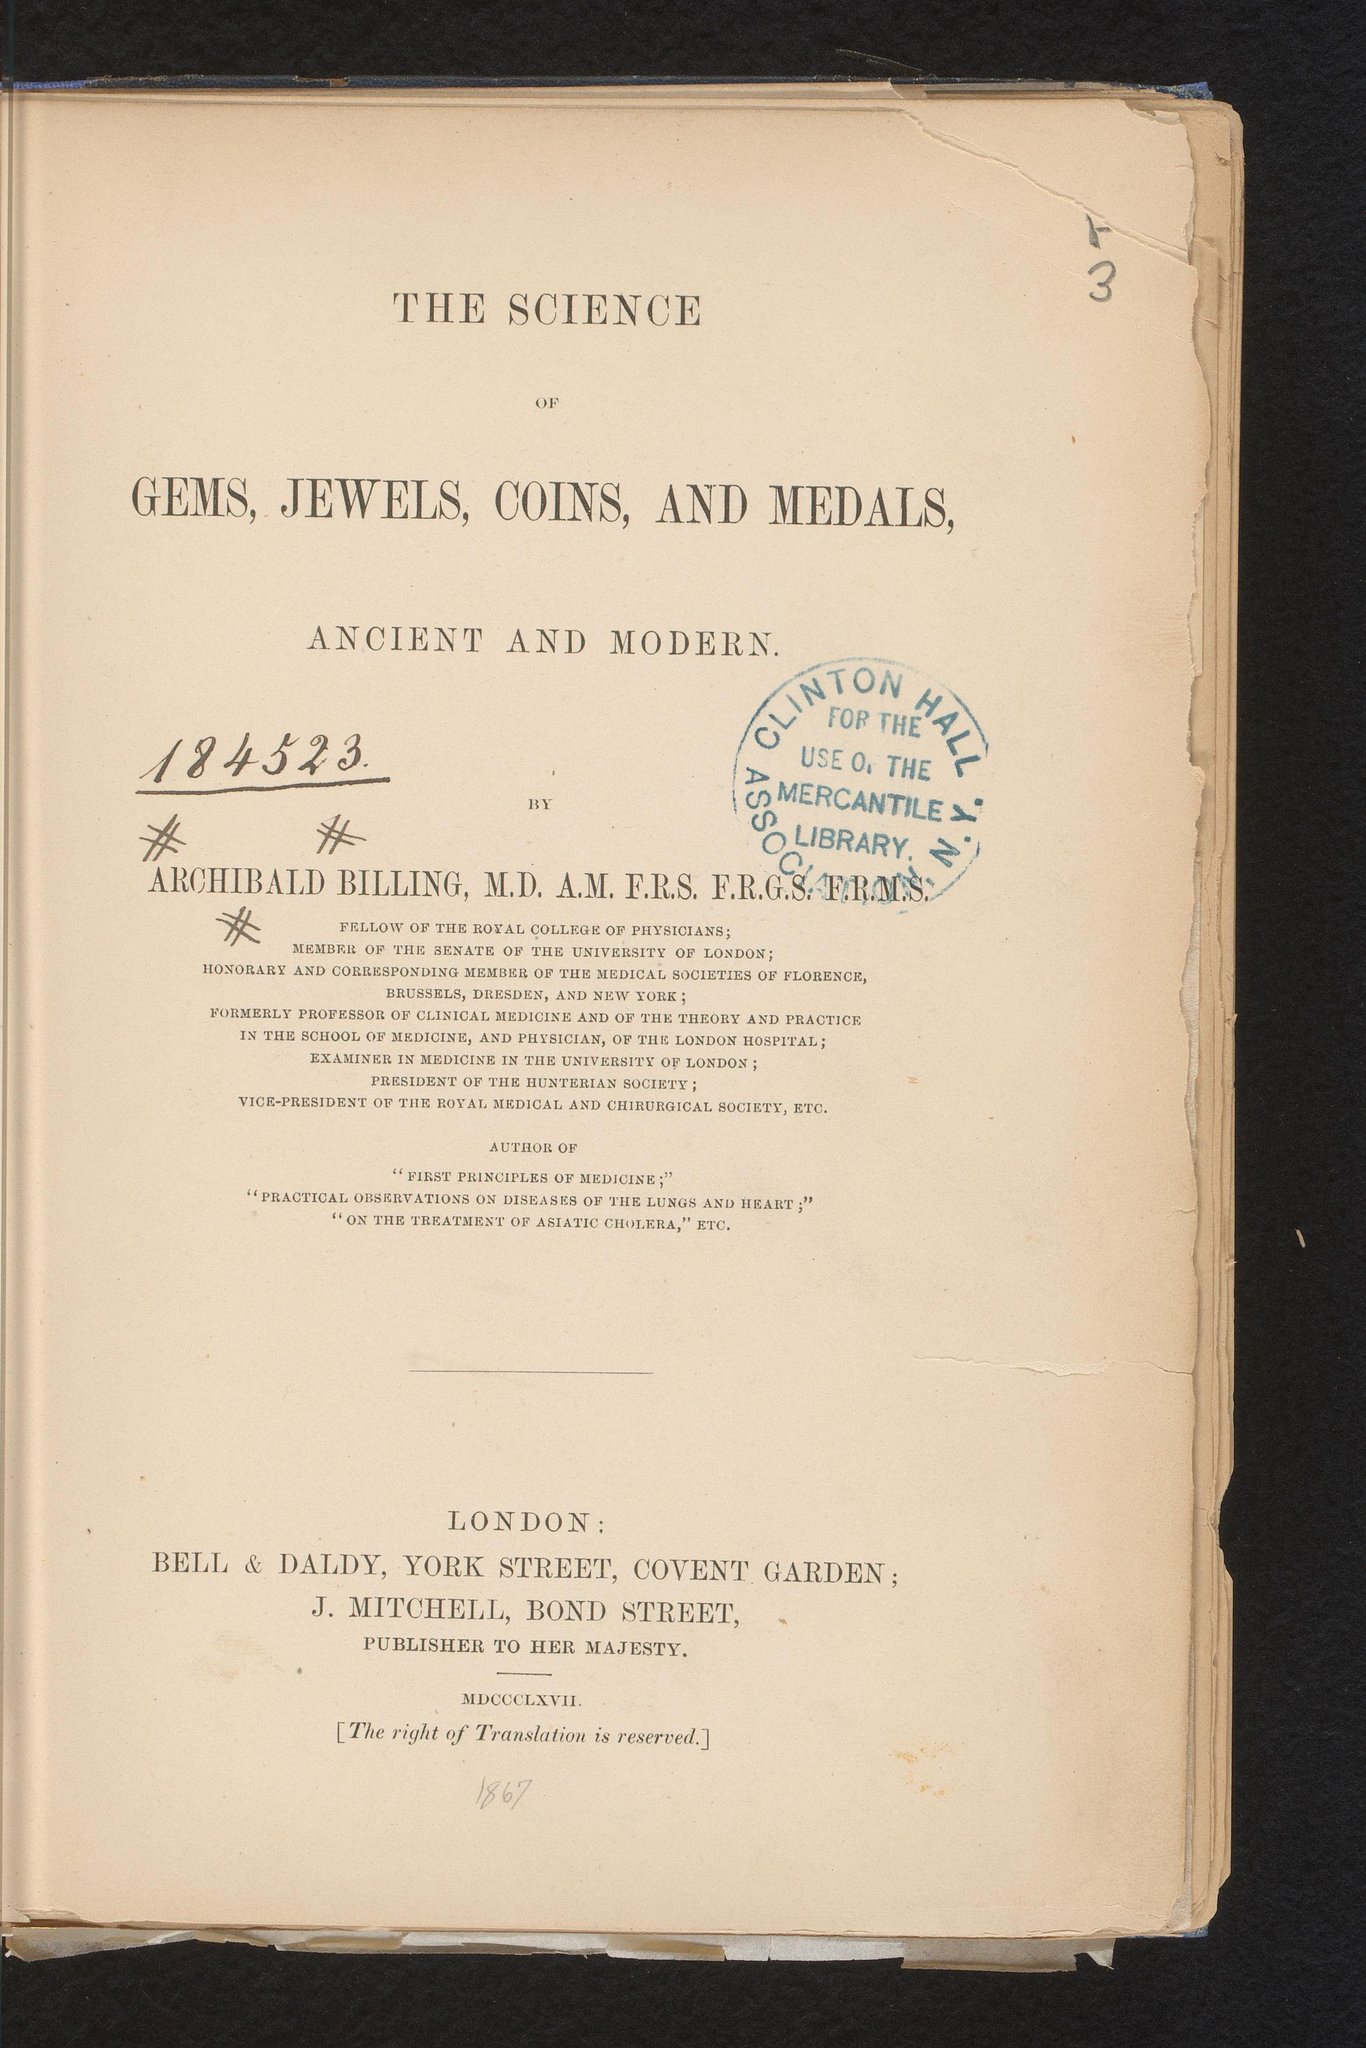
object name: book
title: The science of gems, jewels, coins, and medals, ancient and modern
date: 1867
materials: cardboard, paper, linen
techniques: albumen print, letterpress printing, printing block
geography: london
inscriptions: stamp: ‘CLINTON HALL/ ASSOCIATION, N.Y./ FOR THE/ USE OF THE/ MERCANTILE/ LIBRARY.’, inscription: ‘184523/ # #/ #’, inscription: ‘1867’